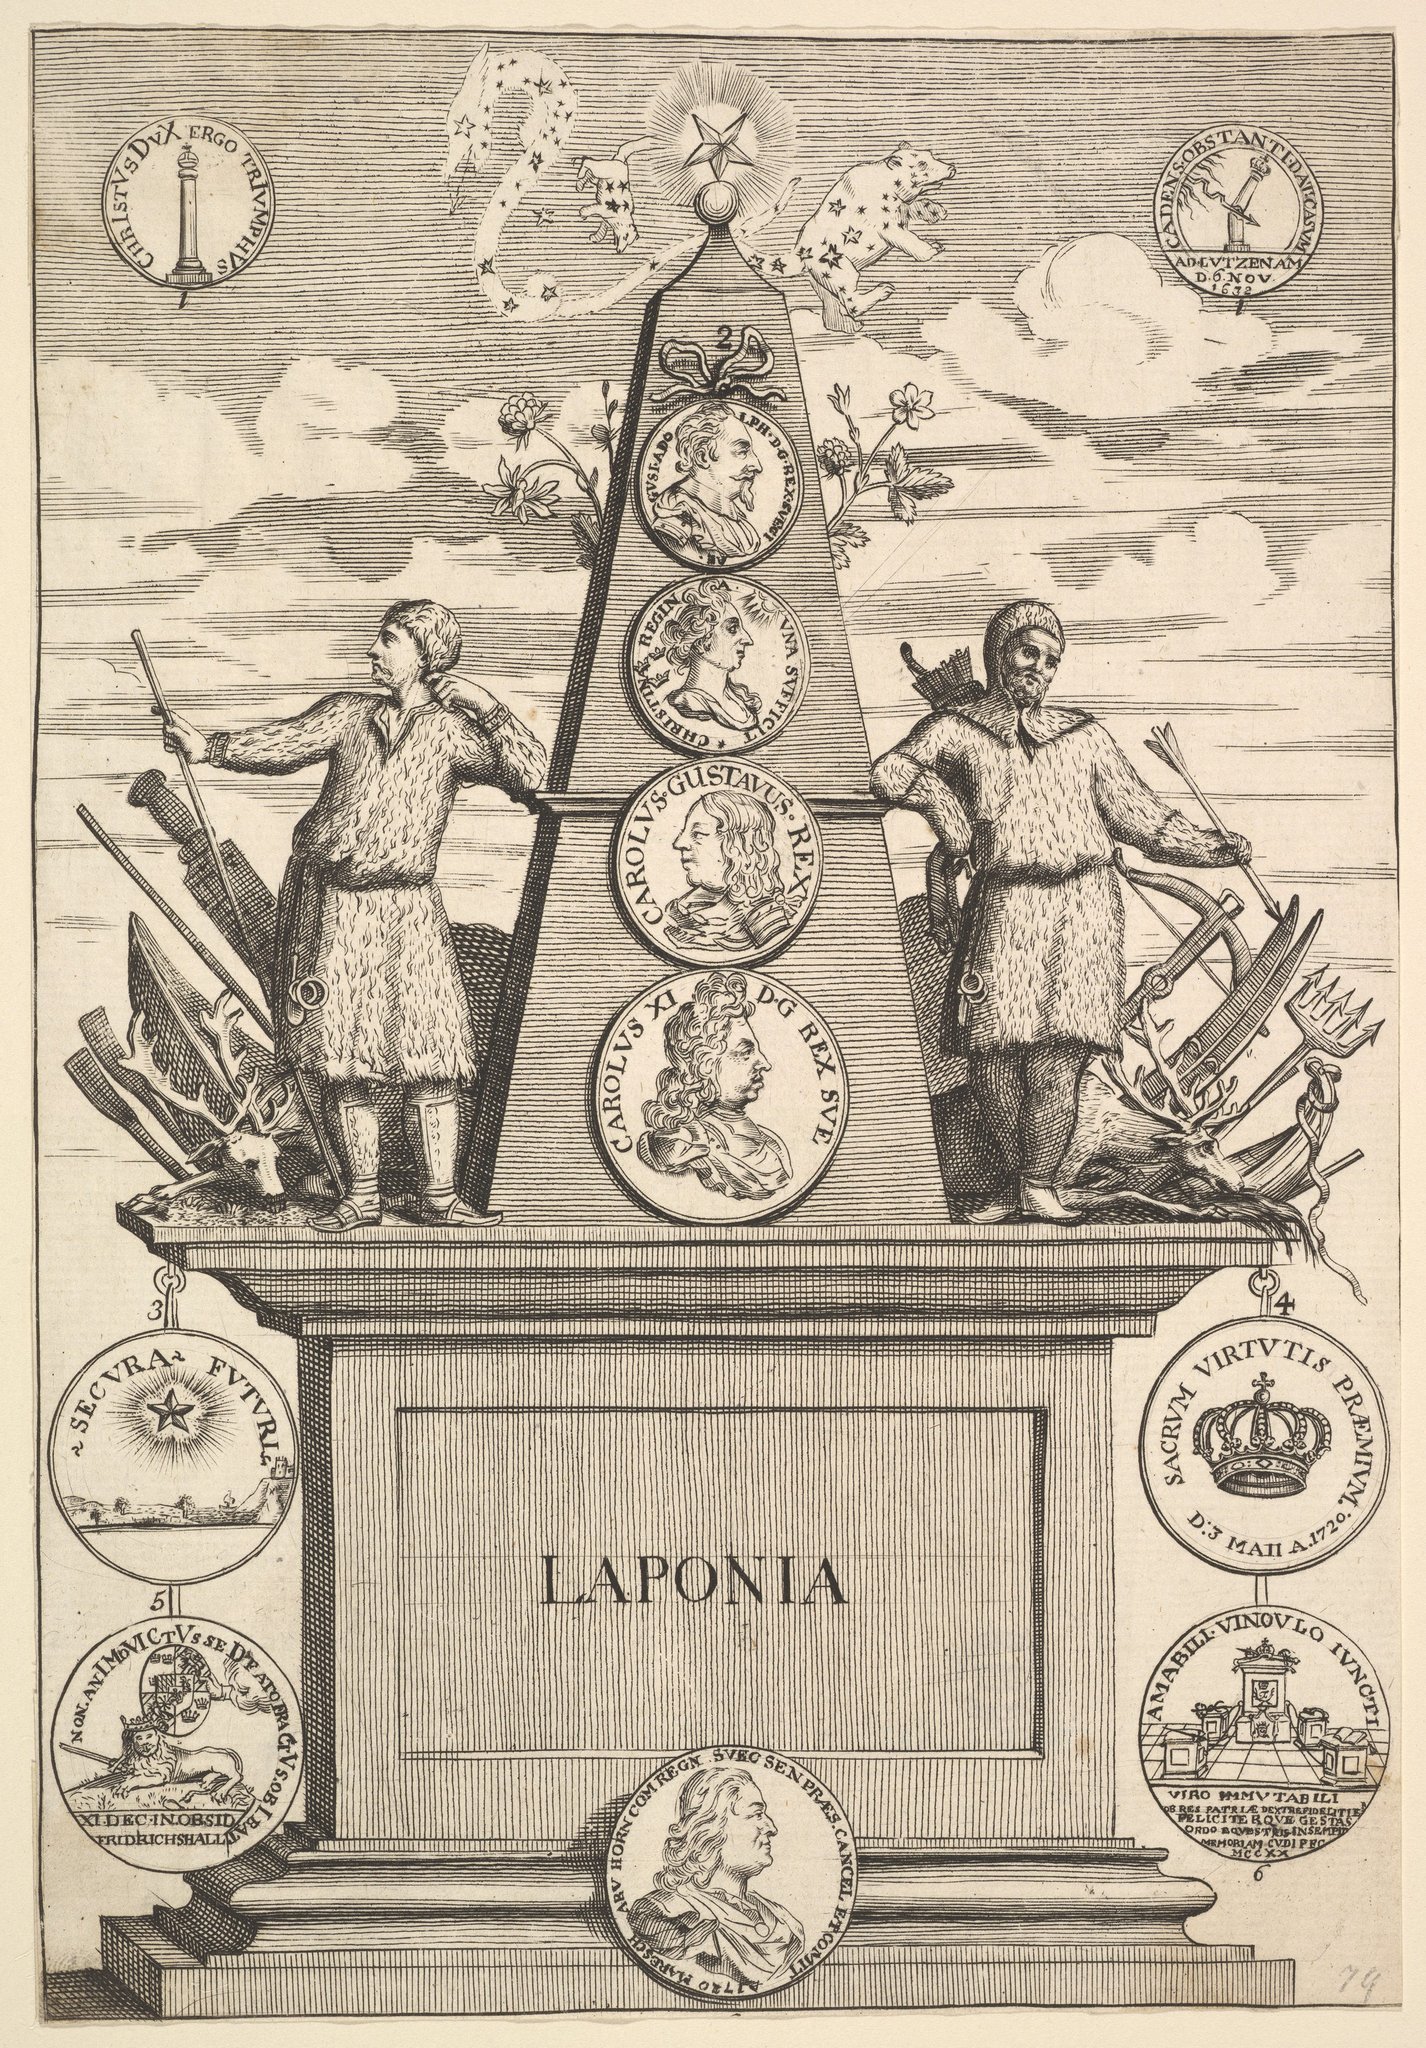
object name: print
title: Laponia (Aubry de La Mottraye's "Travels throughout Europe, Asia and into Part of Africa...," London, 1724, pl. 312)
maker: william hogarth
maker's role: artist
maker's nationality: british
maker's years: 1697-1764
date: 1723-1724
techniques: engraving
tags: obelisks,bow and arrow,men